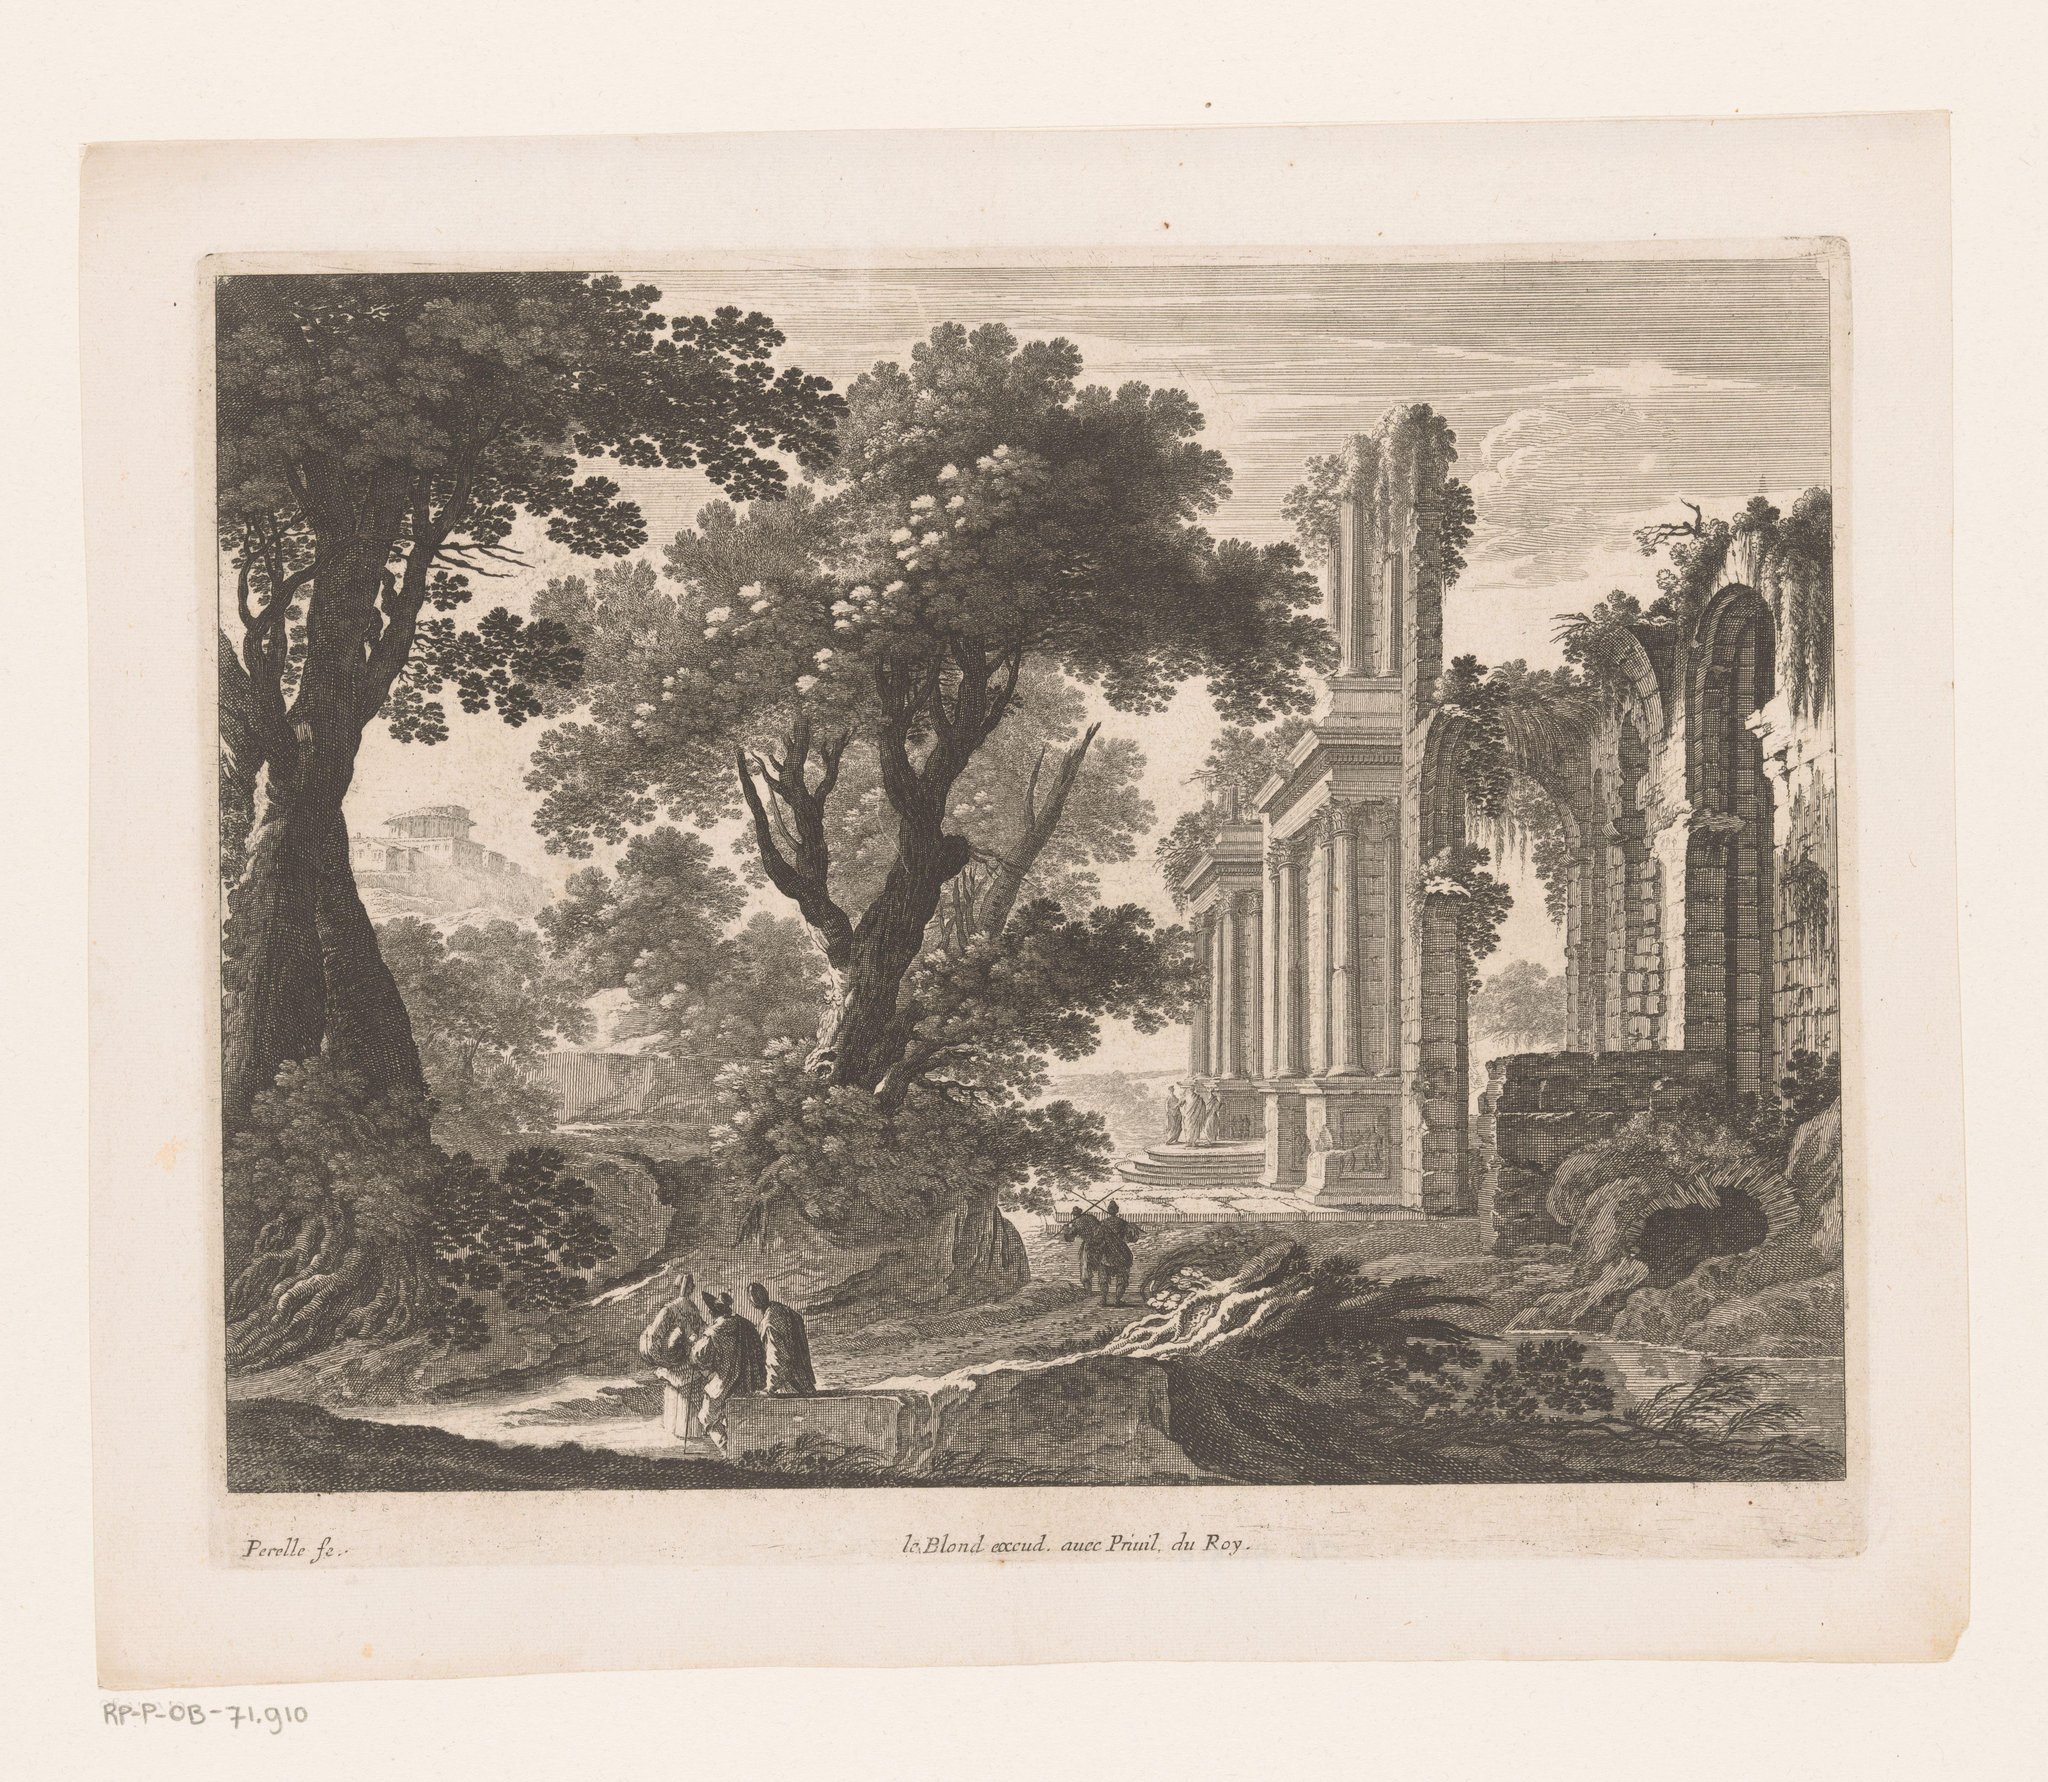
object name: print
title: Landschap met figuren bij ruïne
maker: jean leblond (i)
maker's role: publisher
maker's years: 1590-1666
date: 1613-1666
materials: paper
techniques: etching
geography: paris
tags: landscape with ruins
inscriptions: collector's mark: Lugt 240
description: Prenten met het signatuur 'Perelle' kunnen zowel door vader Gabriel als door zonen Nicolas en Adam gemaakt zijn.